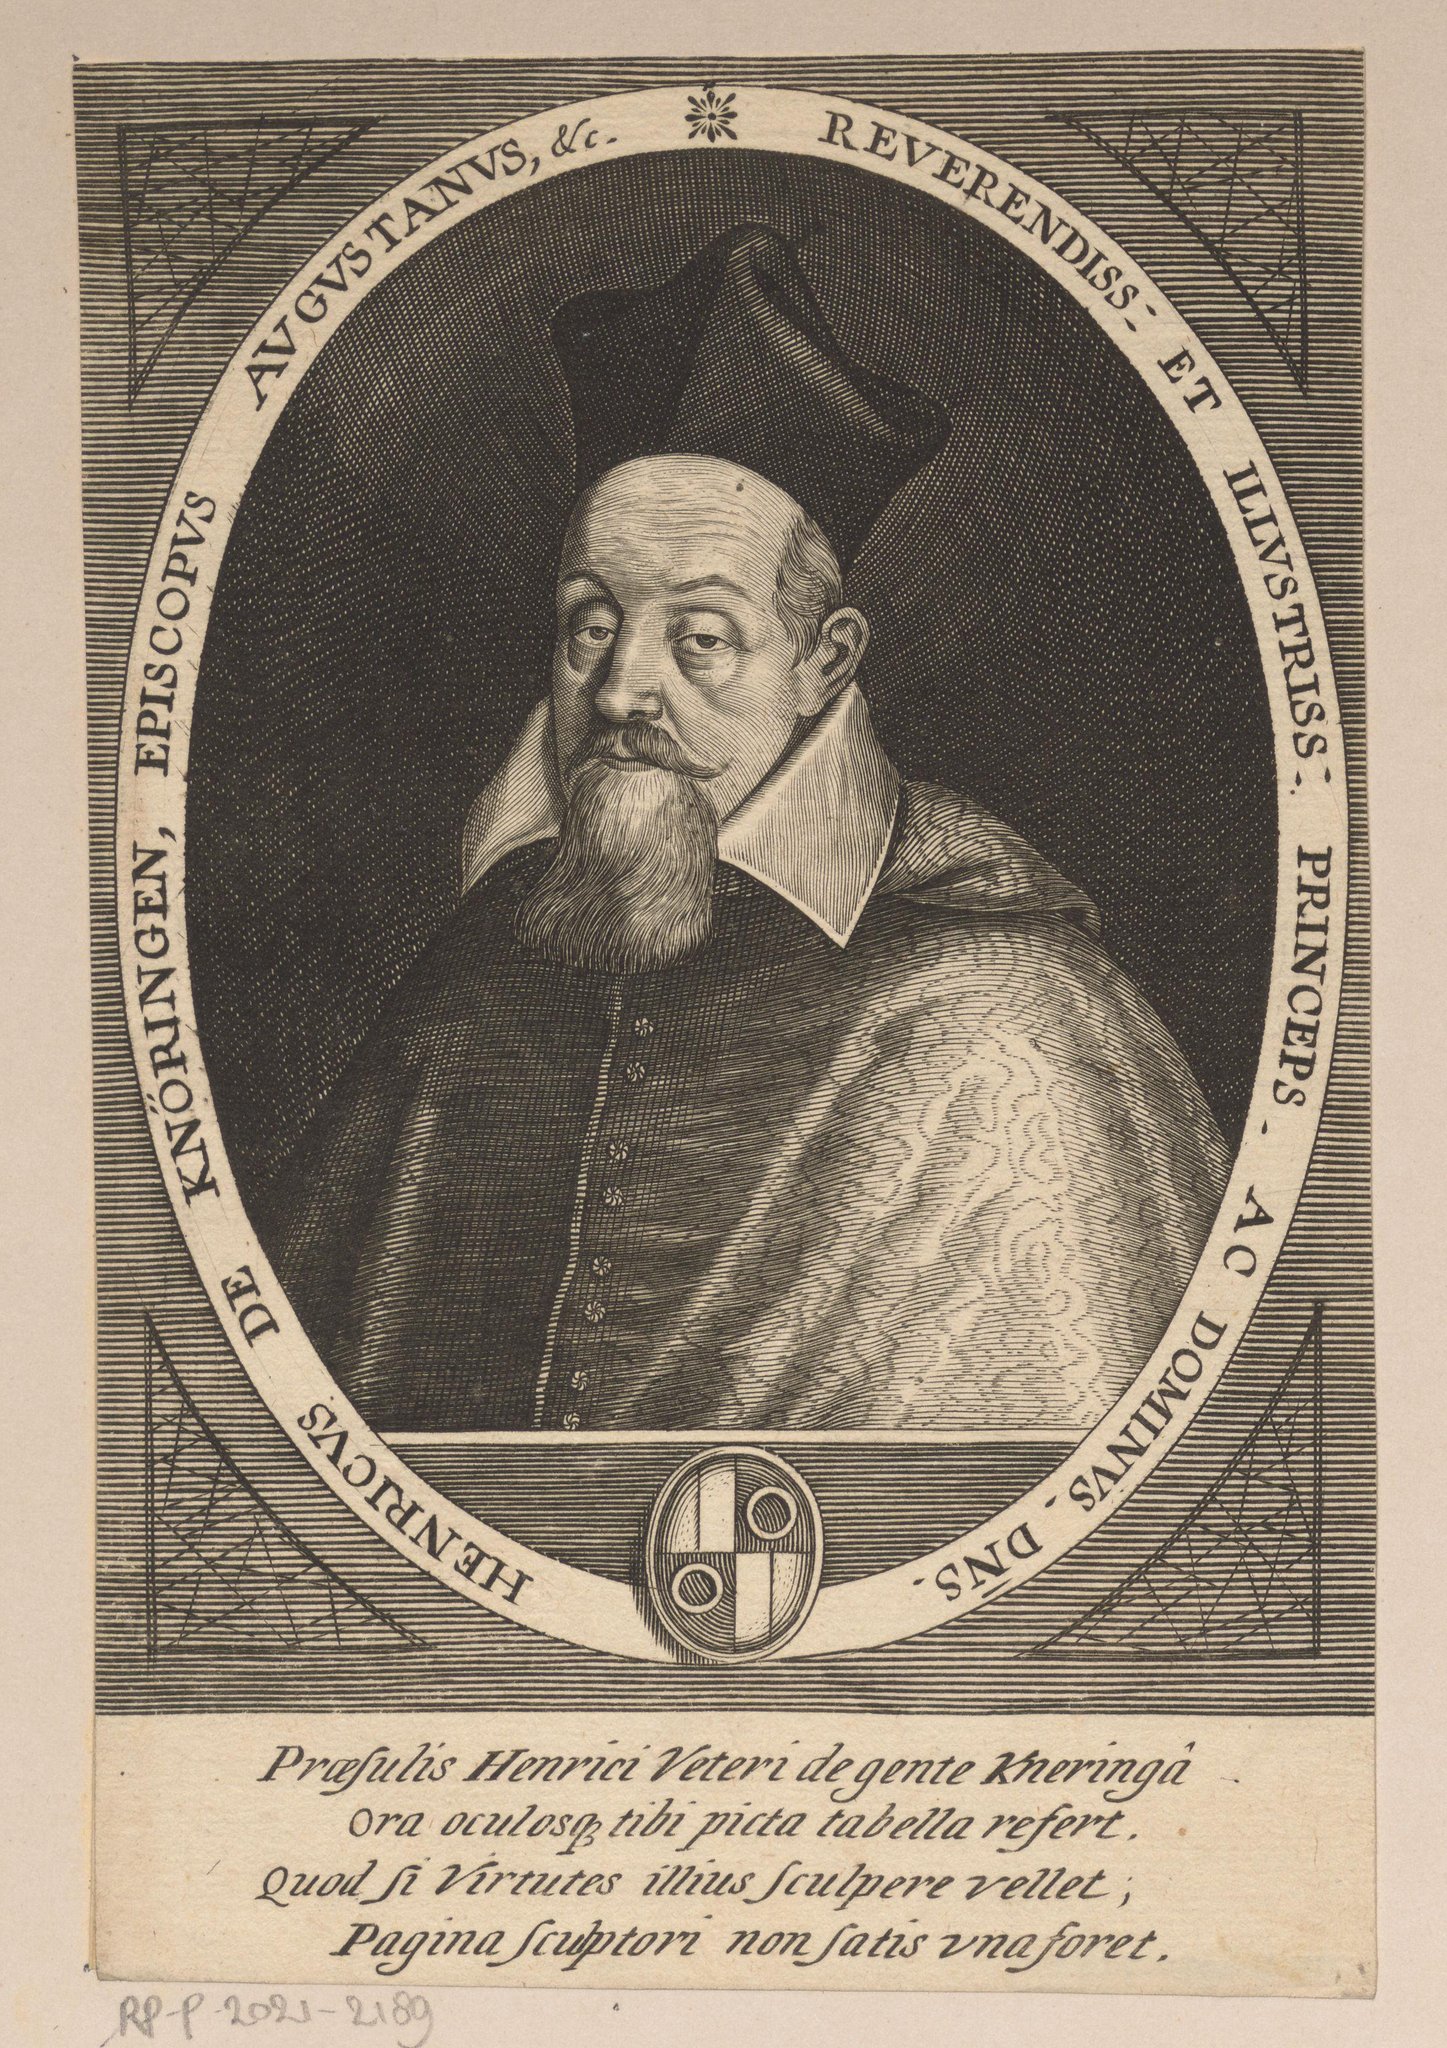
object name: print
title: Portret van Heinrich Knöringen, bisschop van Augsburg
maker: Anonymous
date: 1599-1699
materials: paper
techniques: engraving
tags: heinrich knöringen (bisschop van augsburg), historical persons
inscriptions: collector's mark: Lugt 2233